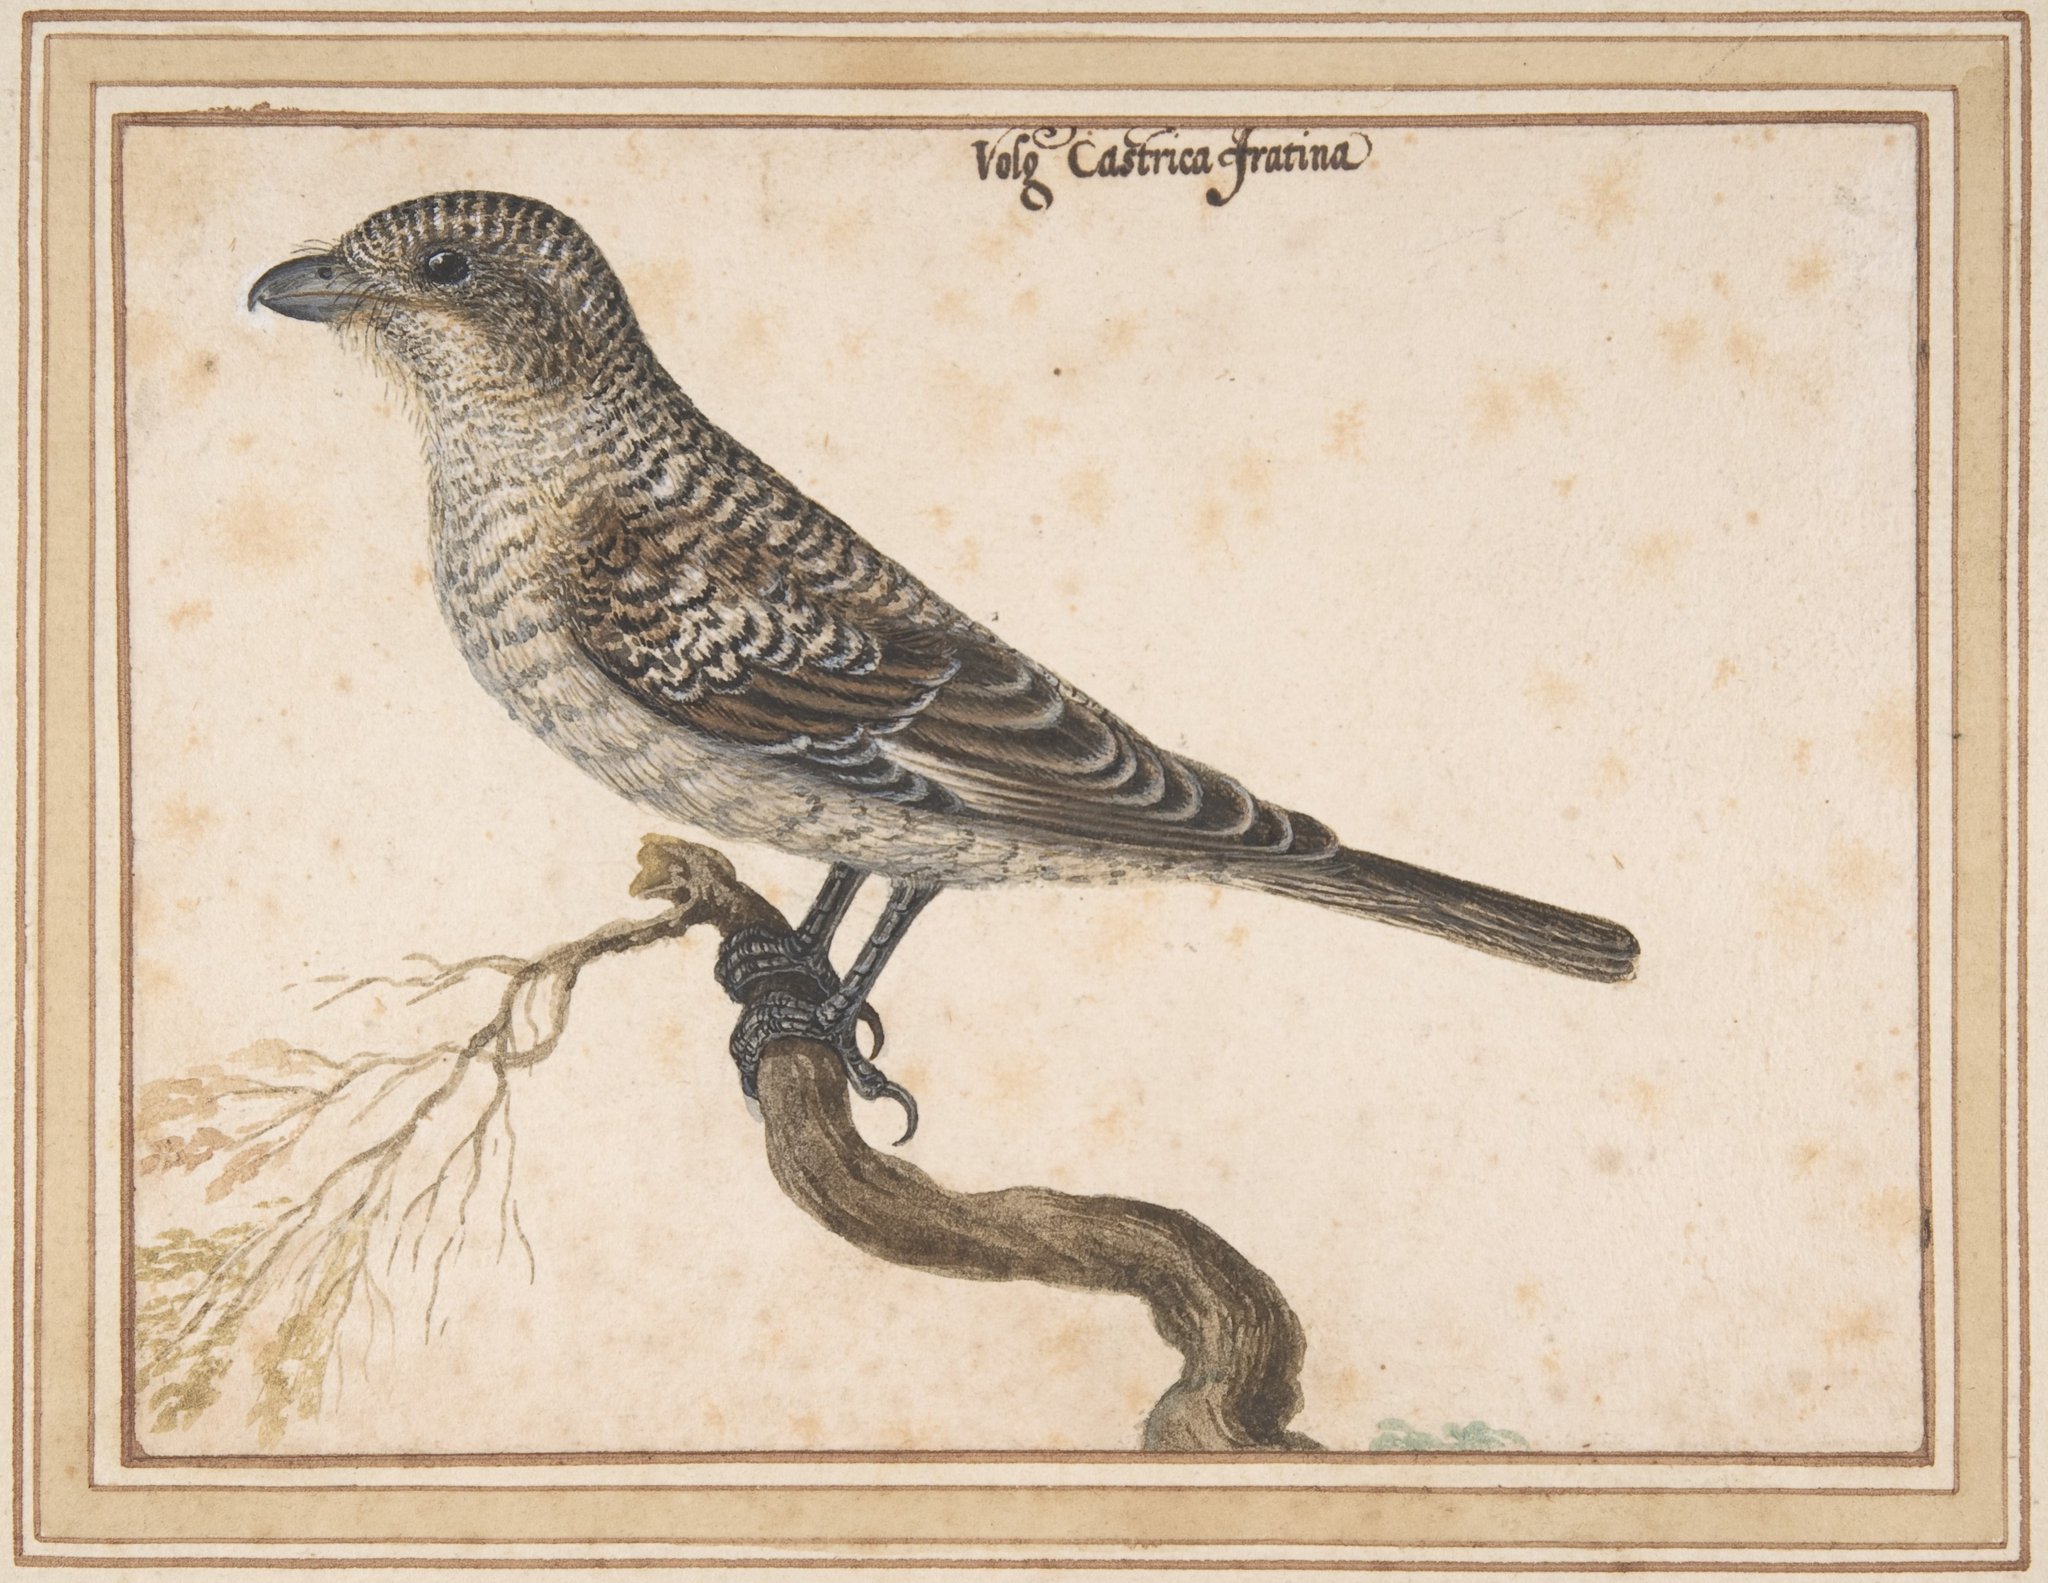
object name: drawing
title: Castrica Fratina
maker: vincenzo leonardi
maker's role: artist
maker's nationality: italian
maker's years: 1590-1646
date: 1601-1700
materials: watercolor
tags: birds,leaves